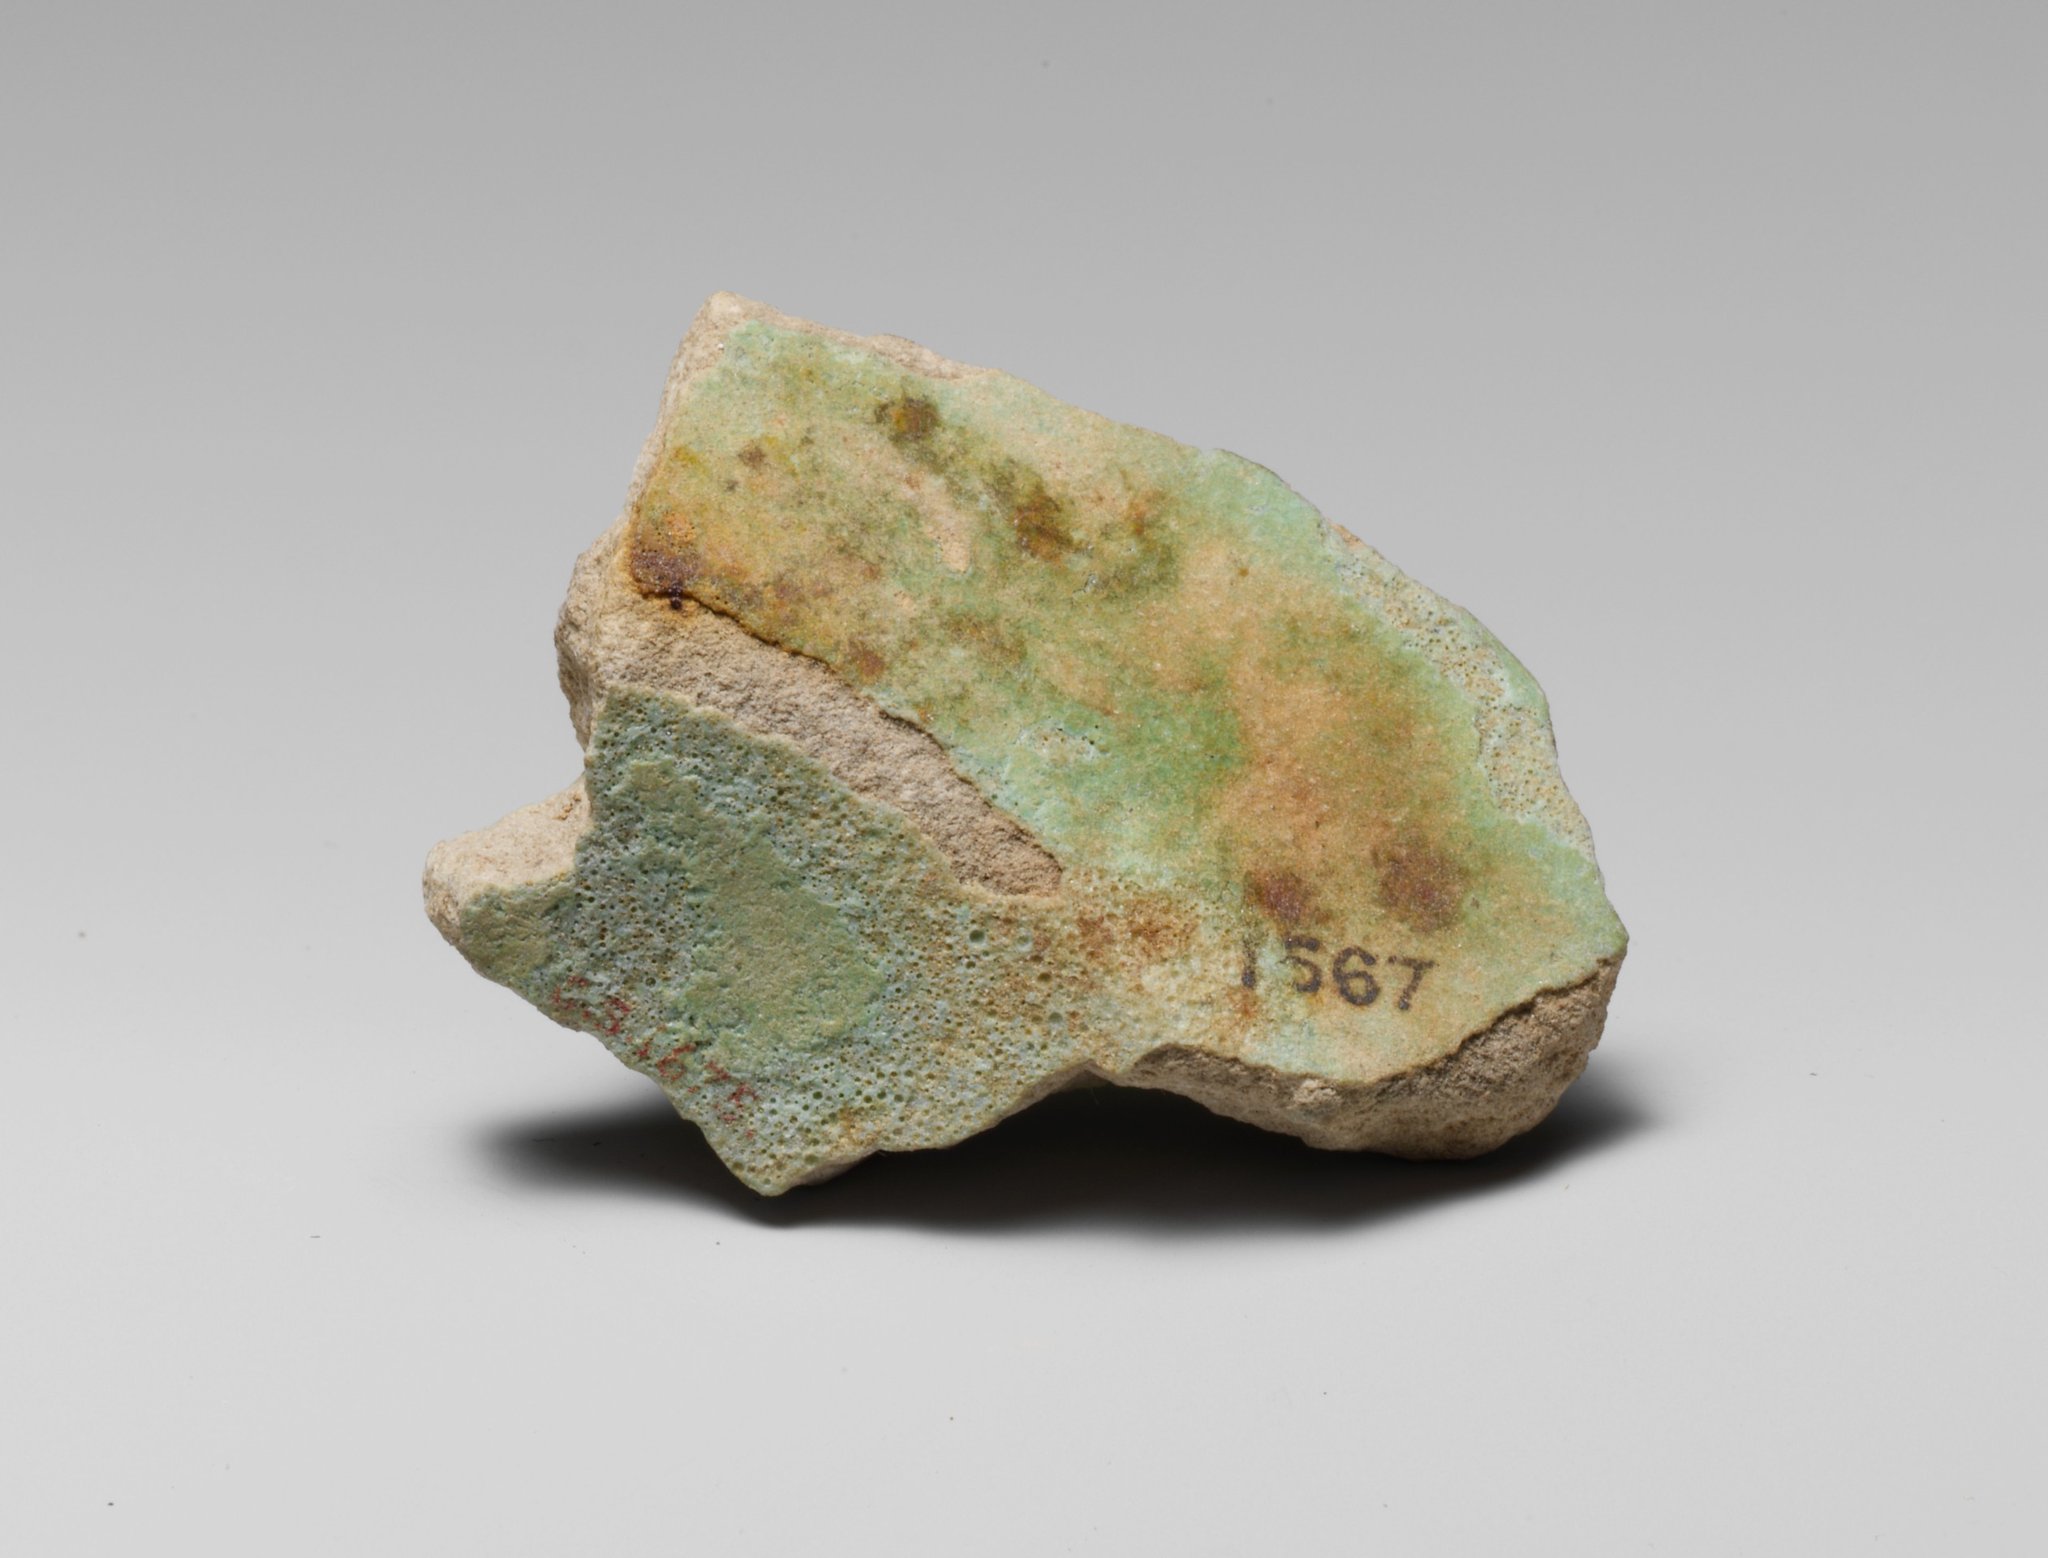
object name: vase fragment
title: Faience lip of a vase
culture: cypriot or egyptian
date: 1300-1101 BCE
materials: faience